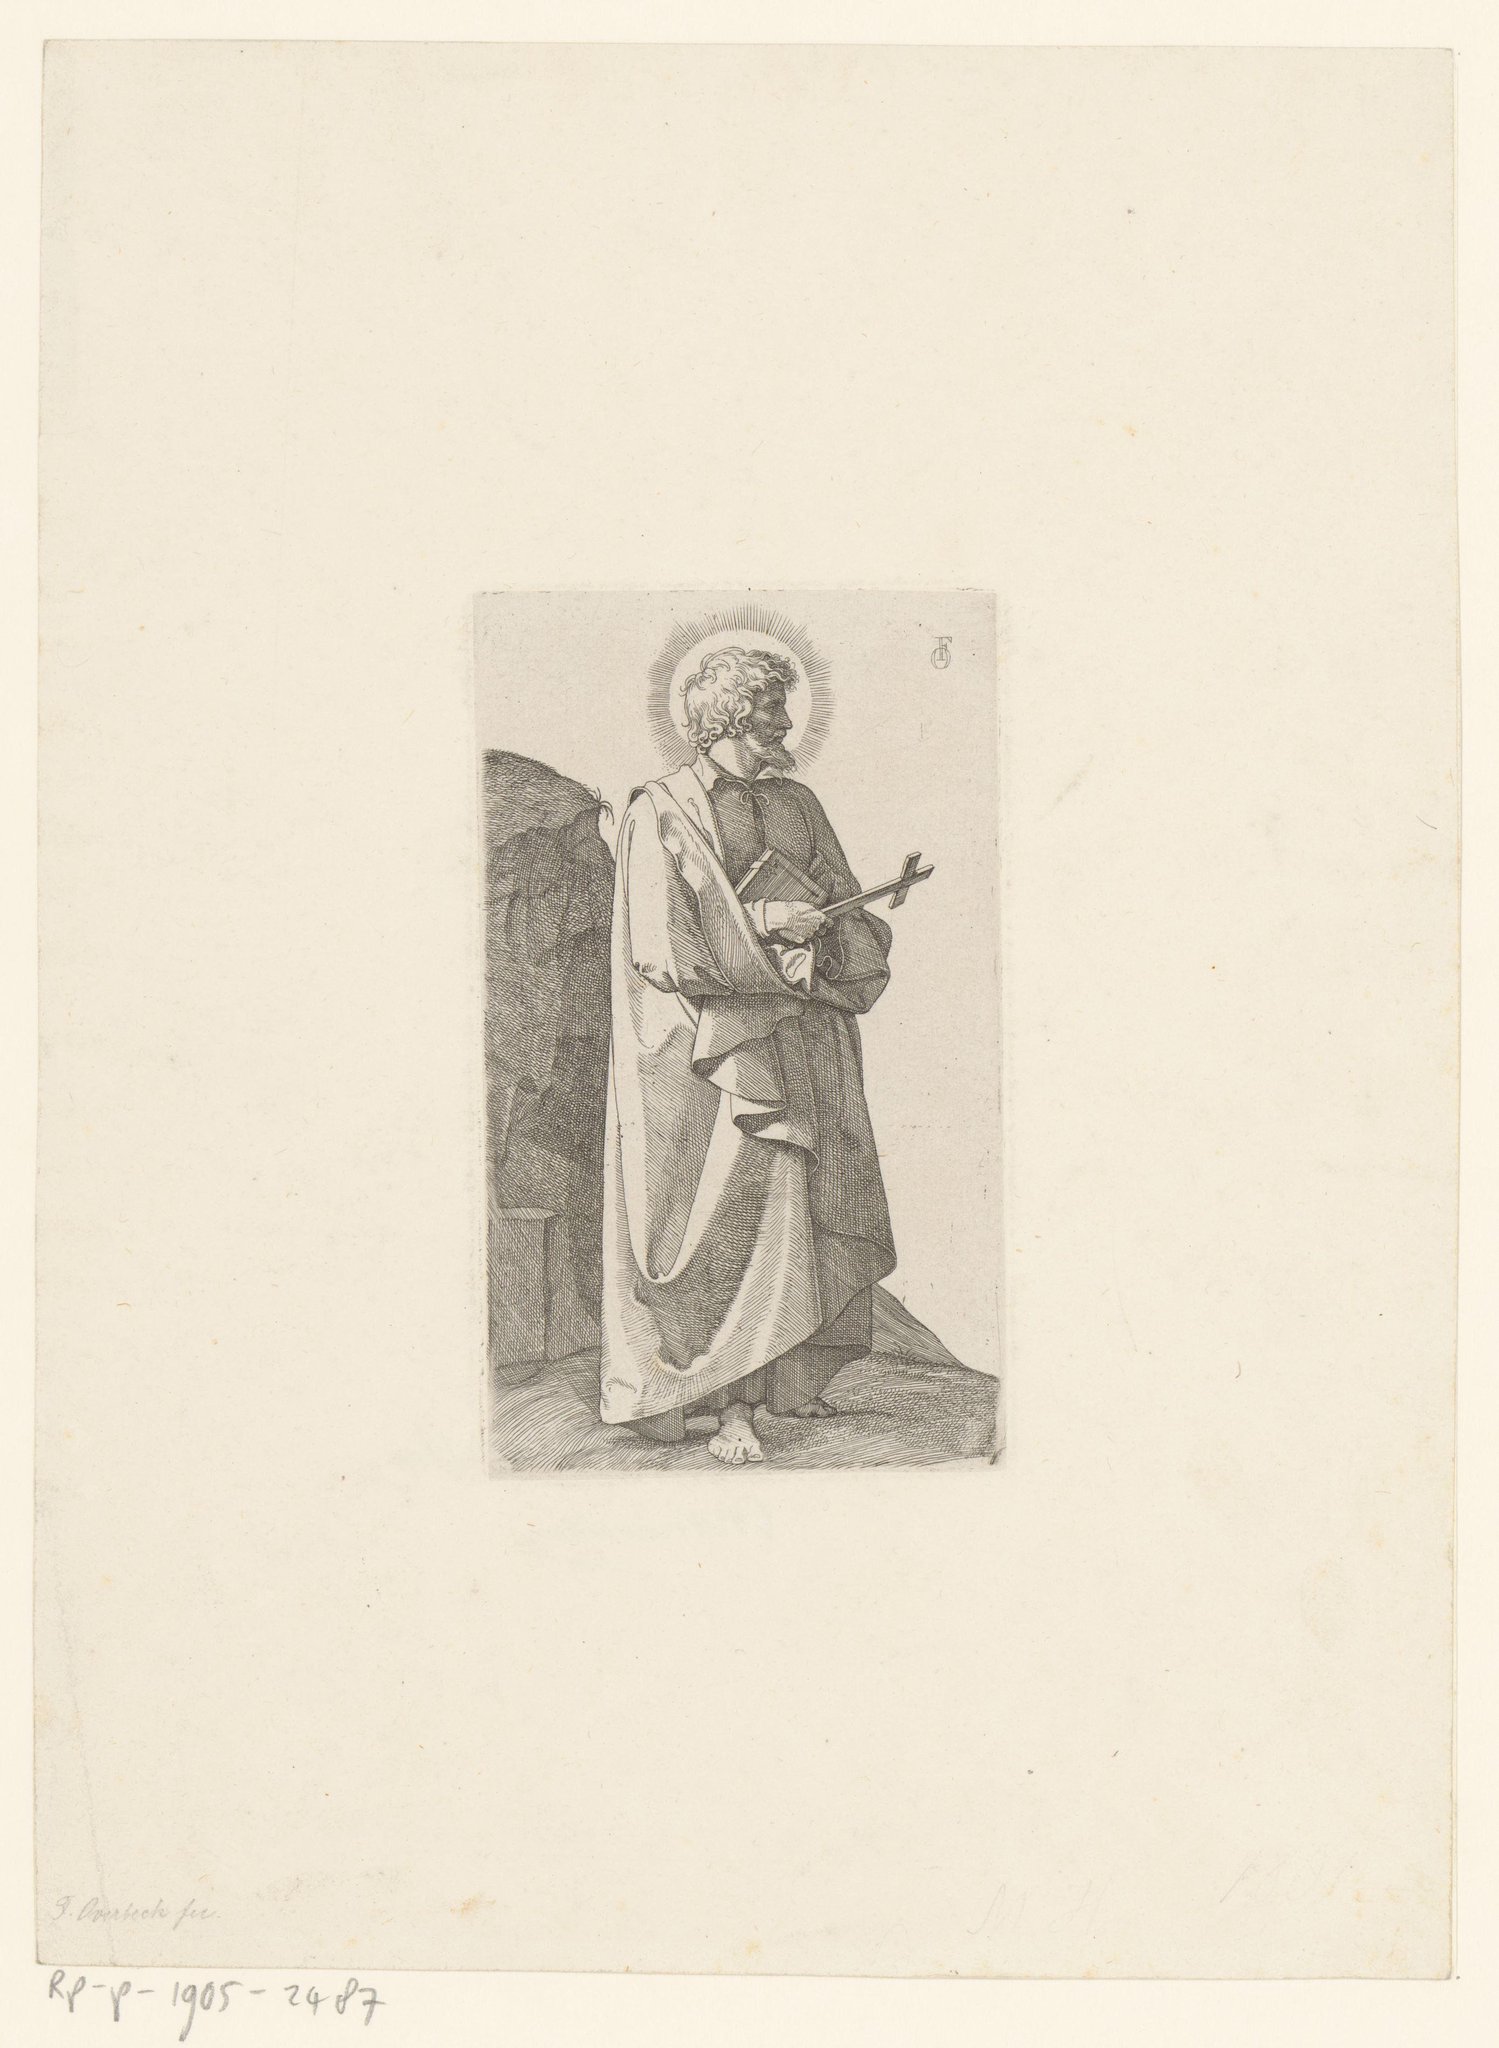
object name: print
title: Apostel Filippus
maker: johann friedrich overbeck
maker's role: painter, print maker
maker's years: 1789-1869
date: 1799-1869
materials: paper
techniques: etching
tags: the apostle philip; possible attributes: book, cross, dish with snake, lance, scroll, stone, sword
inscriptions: collector's mark: Lugt 2228